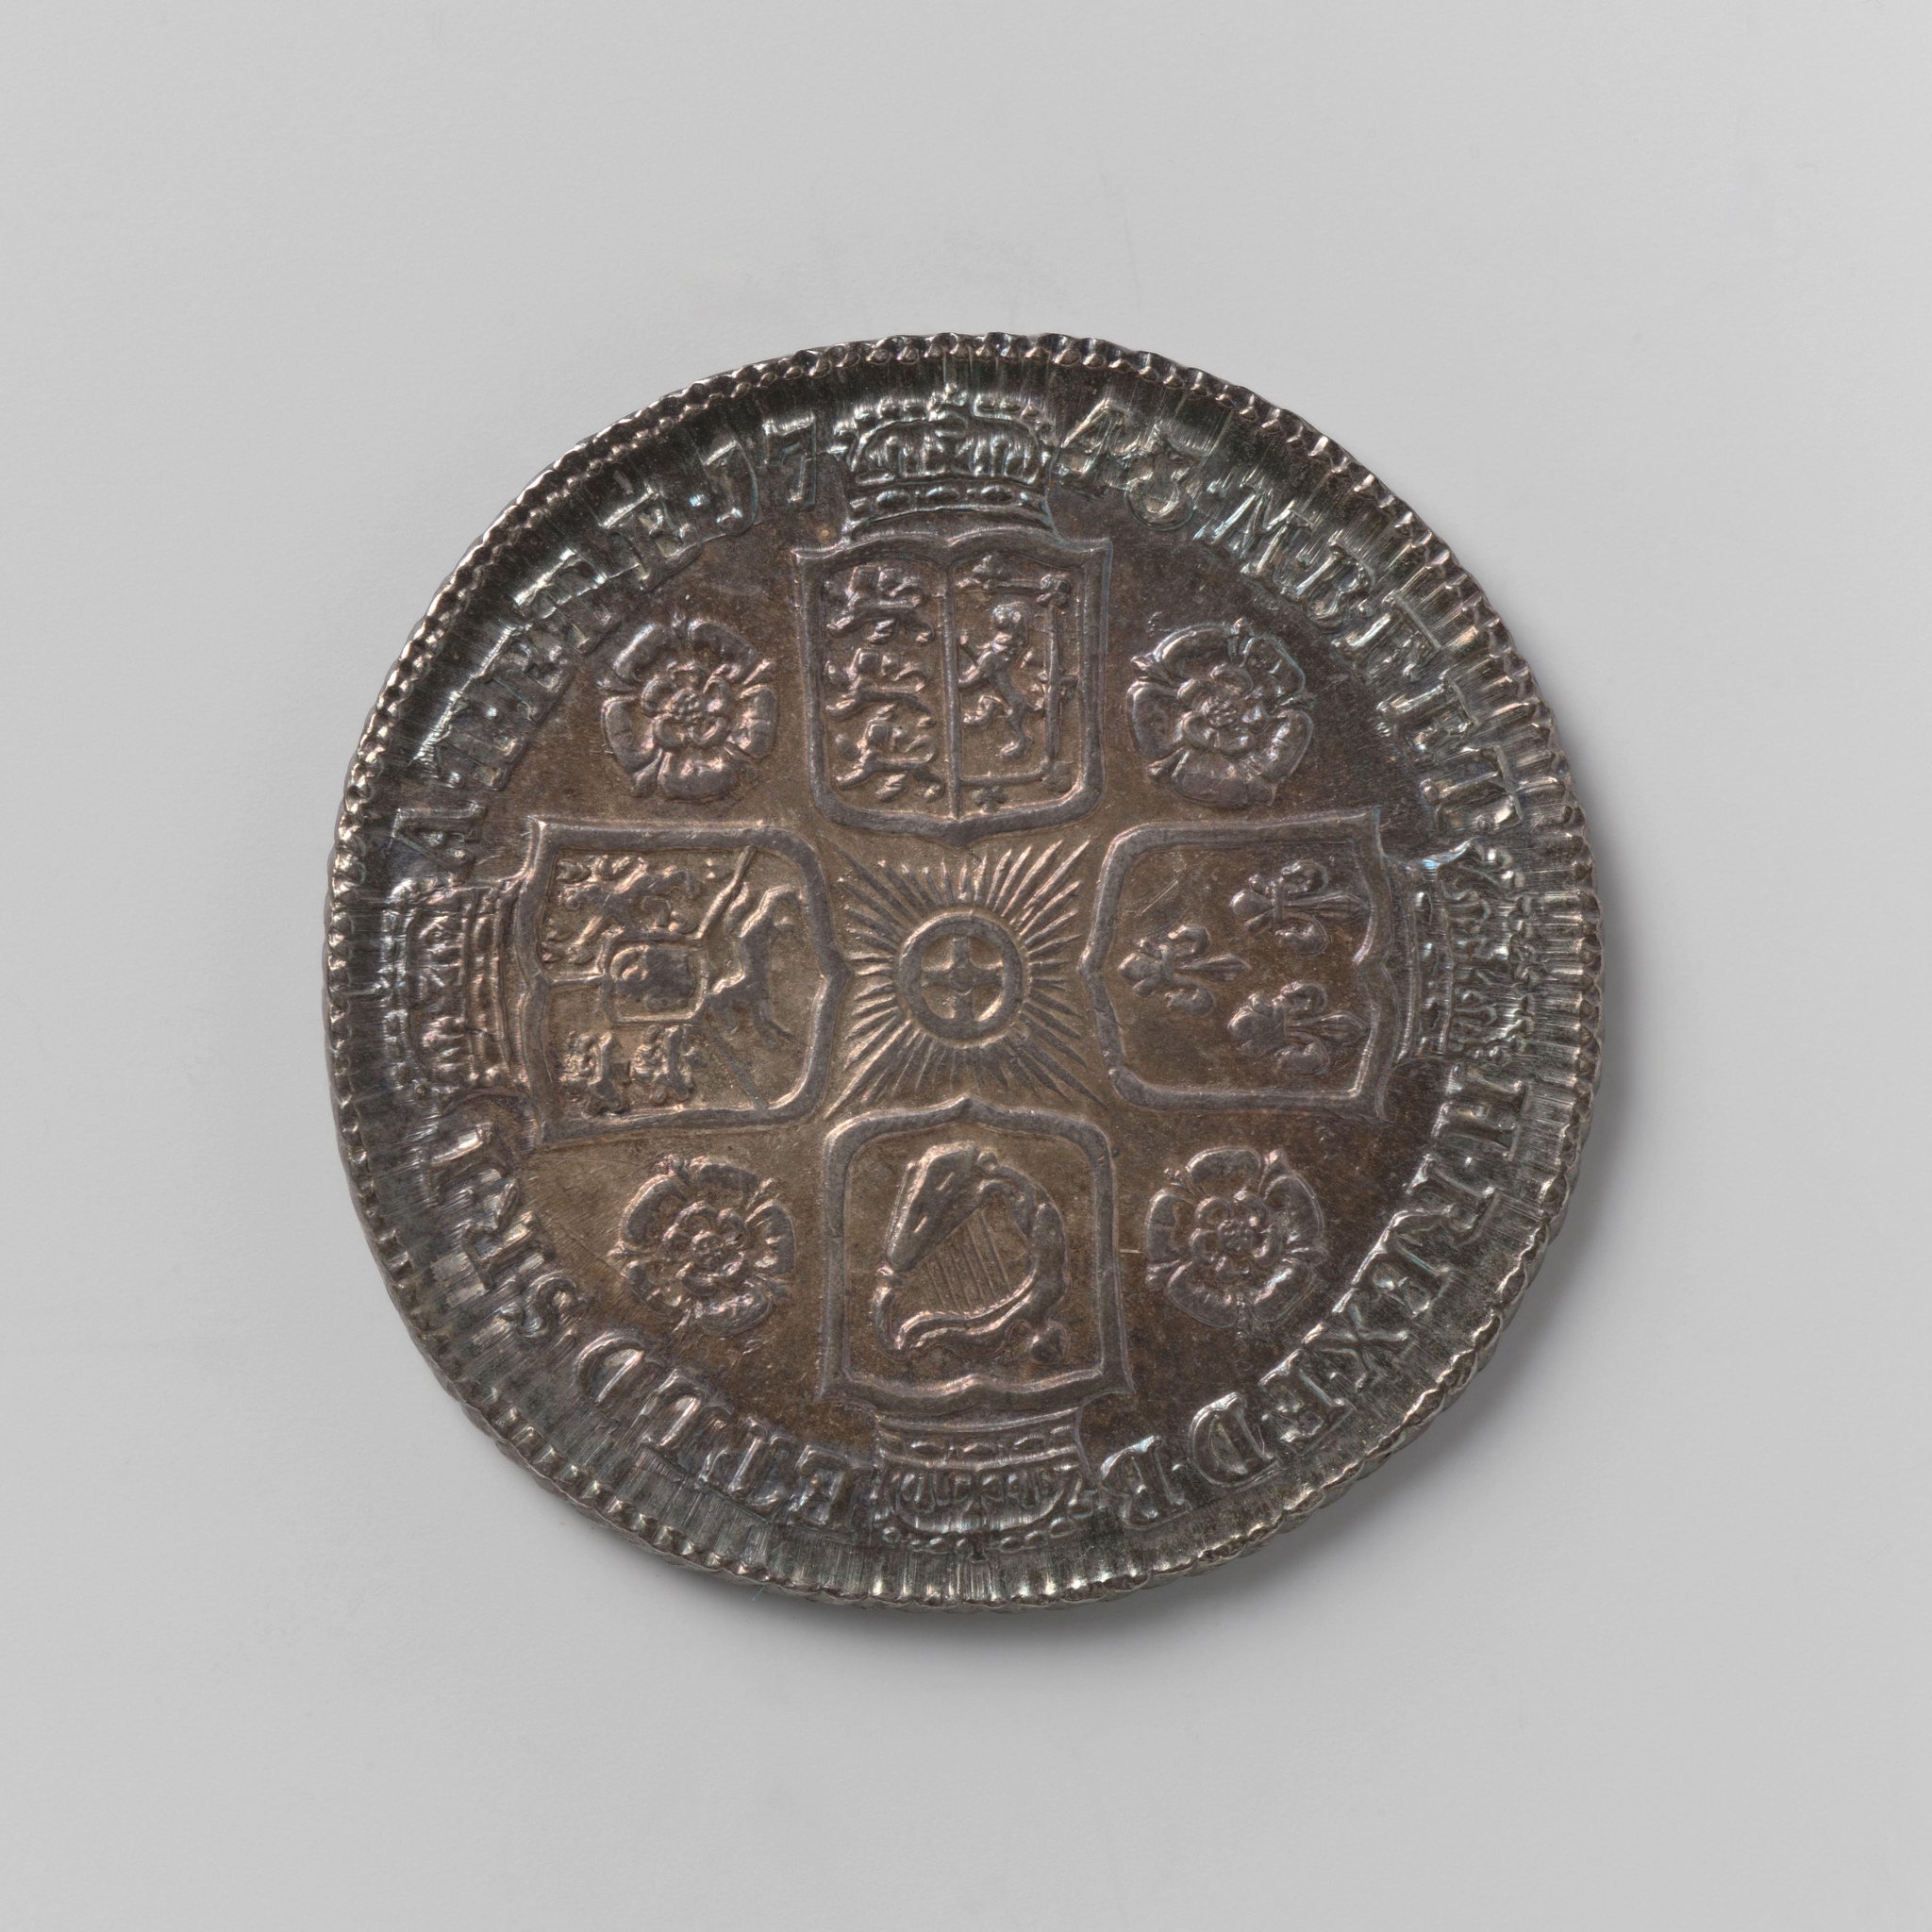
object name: coin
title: Shilling uit Engeland van George II, 1743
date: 1743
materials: silver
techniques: striking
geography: london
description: Zilveren munt. Voorzijde: gelauwerd borstbeeld van de koning naar links. Keerzijde: rondom kruis binnen cirkel, waaromheen stralen, vier in kruisvorm geplaatste gekroonde wapenschilden. In de hoeken vier rozen. Jaartal bovenaan in omschrift. Kabelrand.